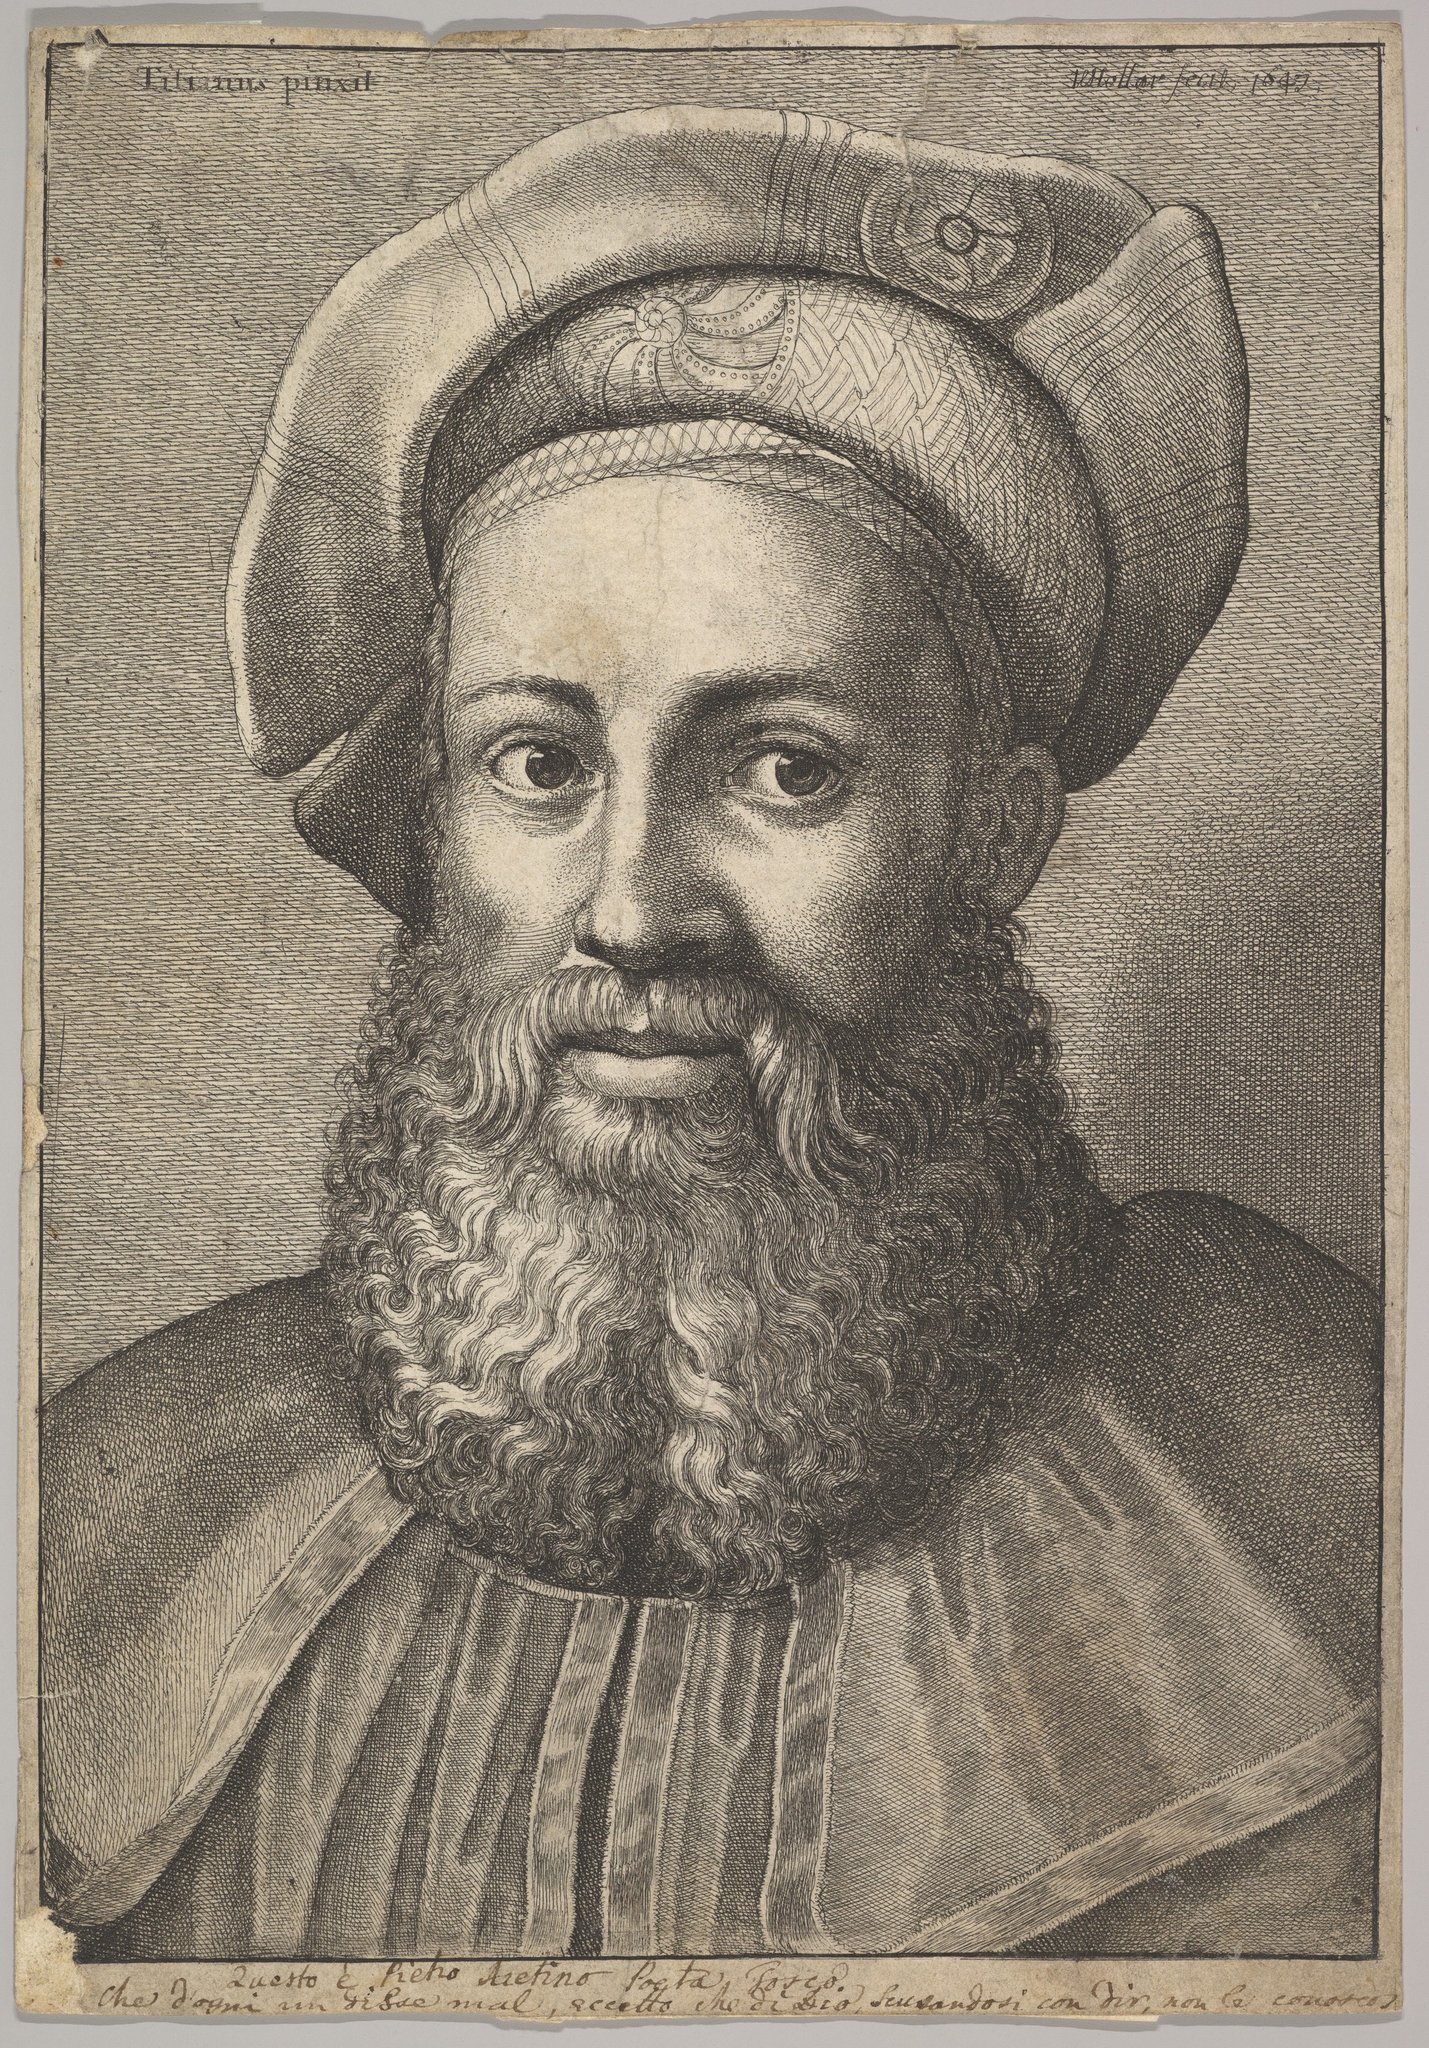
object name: print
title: Pietro Aretino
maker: wenceslaus hollar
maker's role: artist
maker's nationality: bohemian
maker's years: 1607-1677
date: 1640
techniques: etching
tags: men,portraits